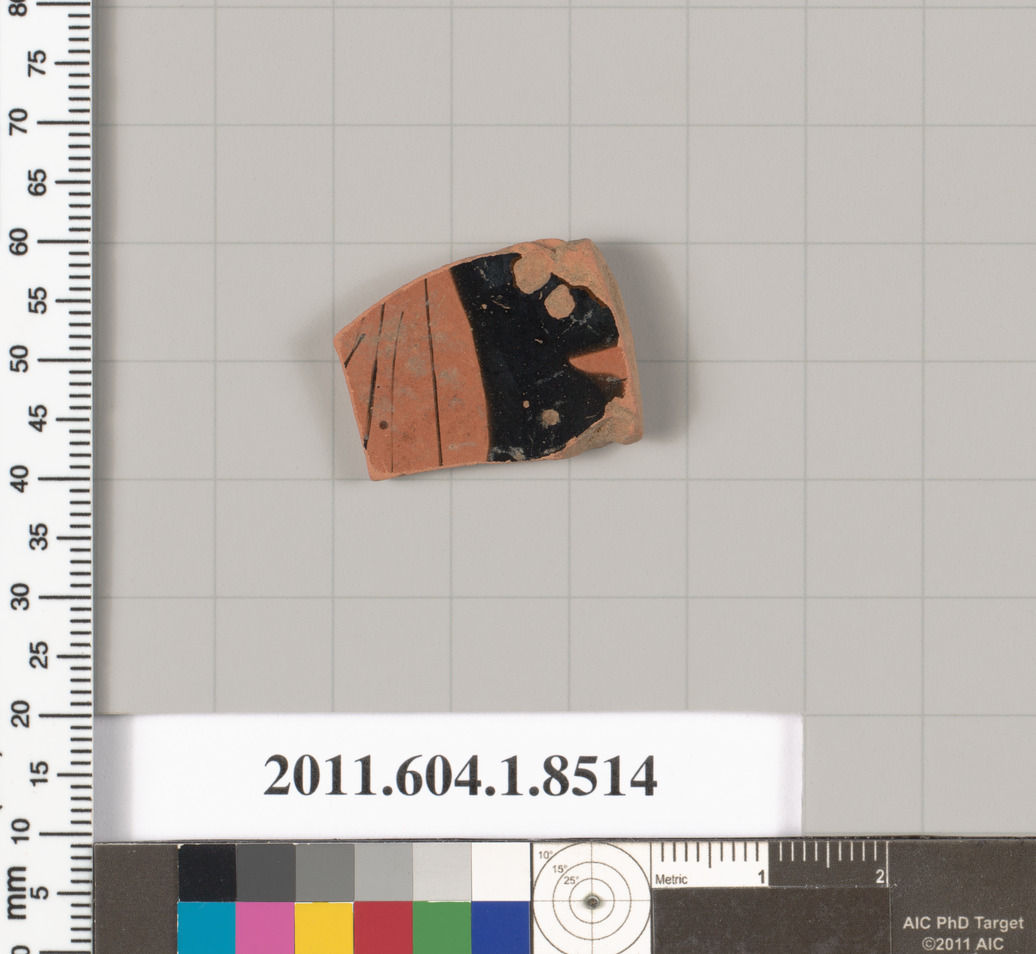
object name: kylix fragment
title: Terracotta fragment of a stemless kylix (drinking cup)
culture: greek, attic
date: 467-435 BCE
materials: terracotta